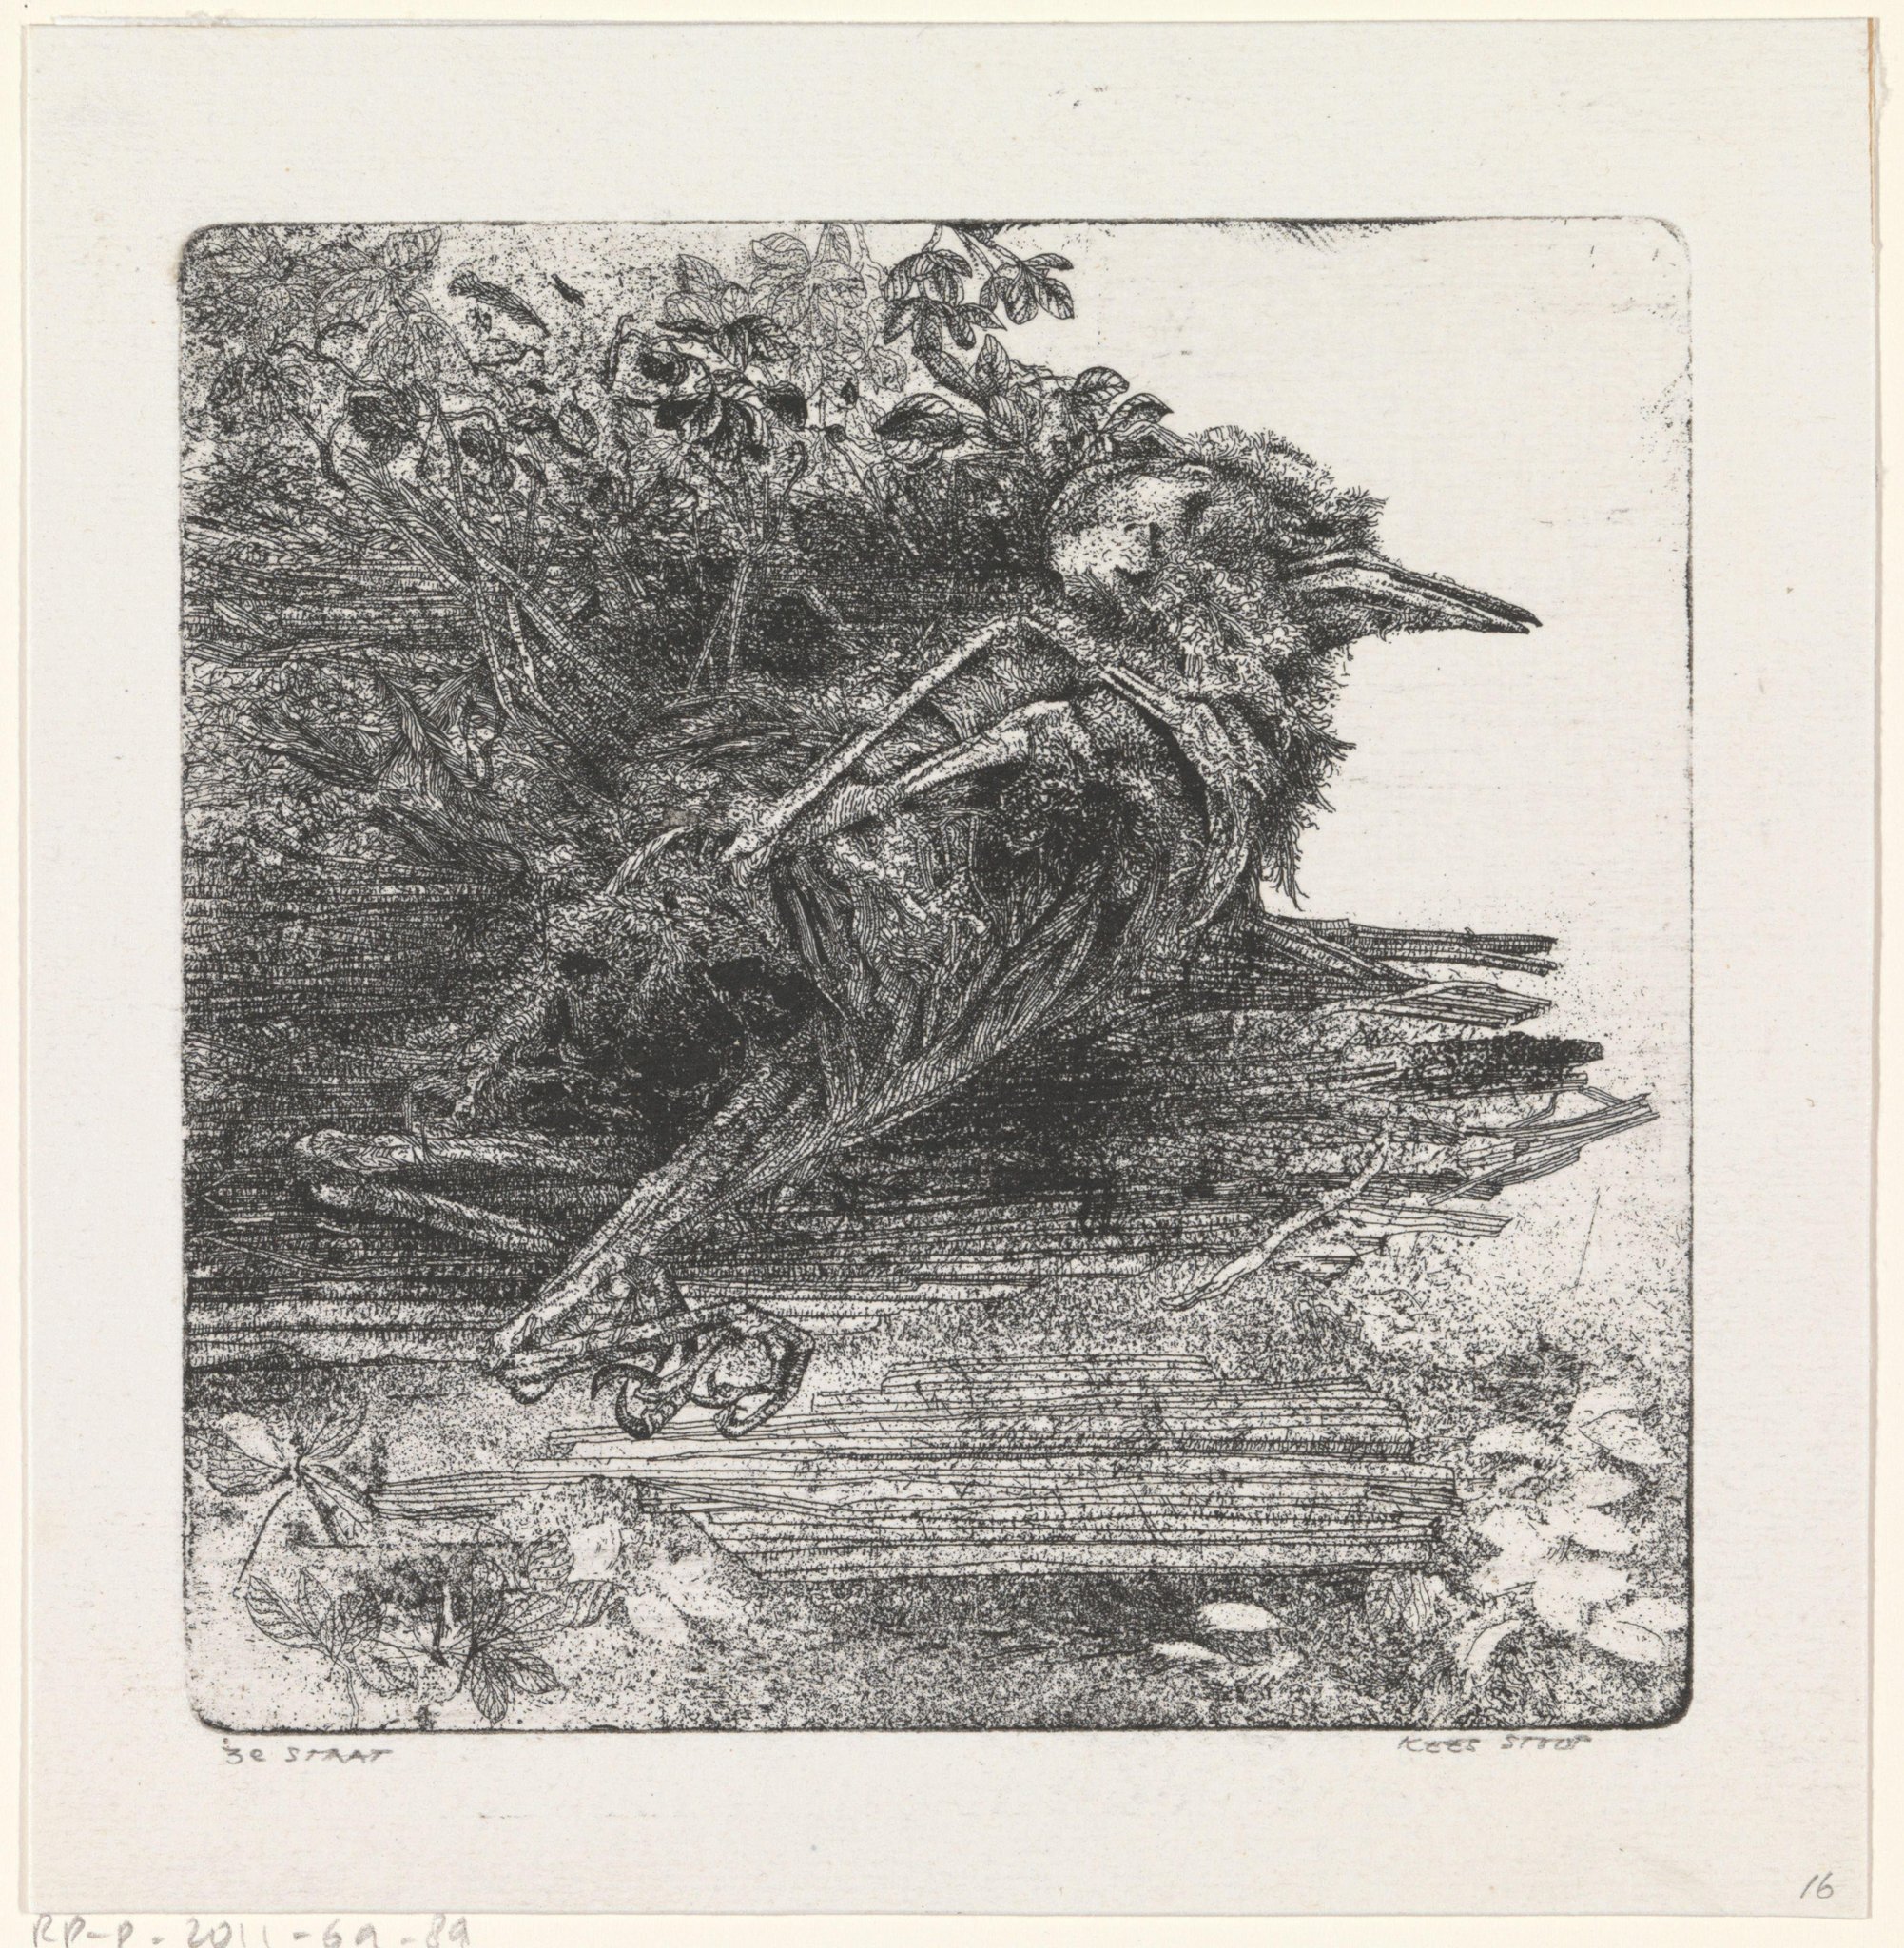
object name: print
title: Dode vogel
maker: kees stoop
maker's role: draughtsman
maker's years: 1929-2019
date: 1975-1977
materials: paper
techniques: etching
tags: birds (+ dying animal; death of animal; dead animal)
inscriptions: inscription: ‘1e STAAT’, signature: ‘KEES STOOP’, date: ‘'79’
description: Dode, in staat van ontbinding verkerende vogel.